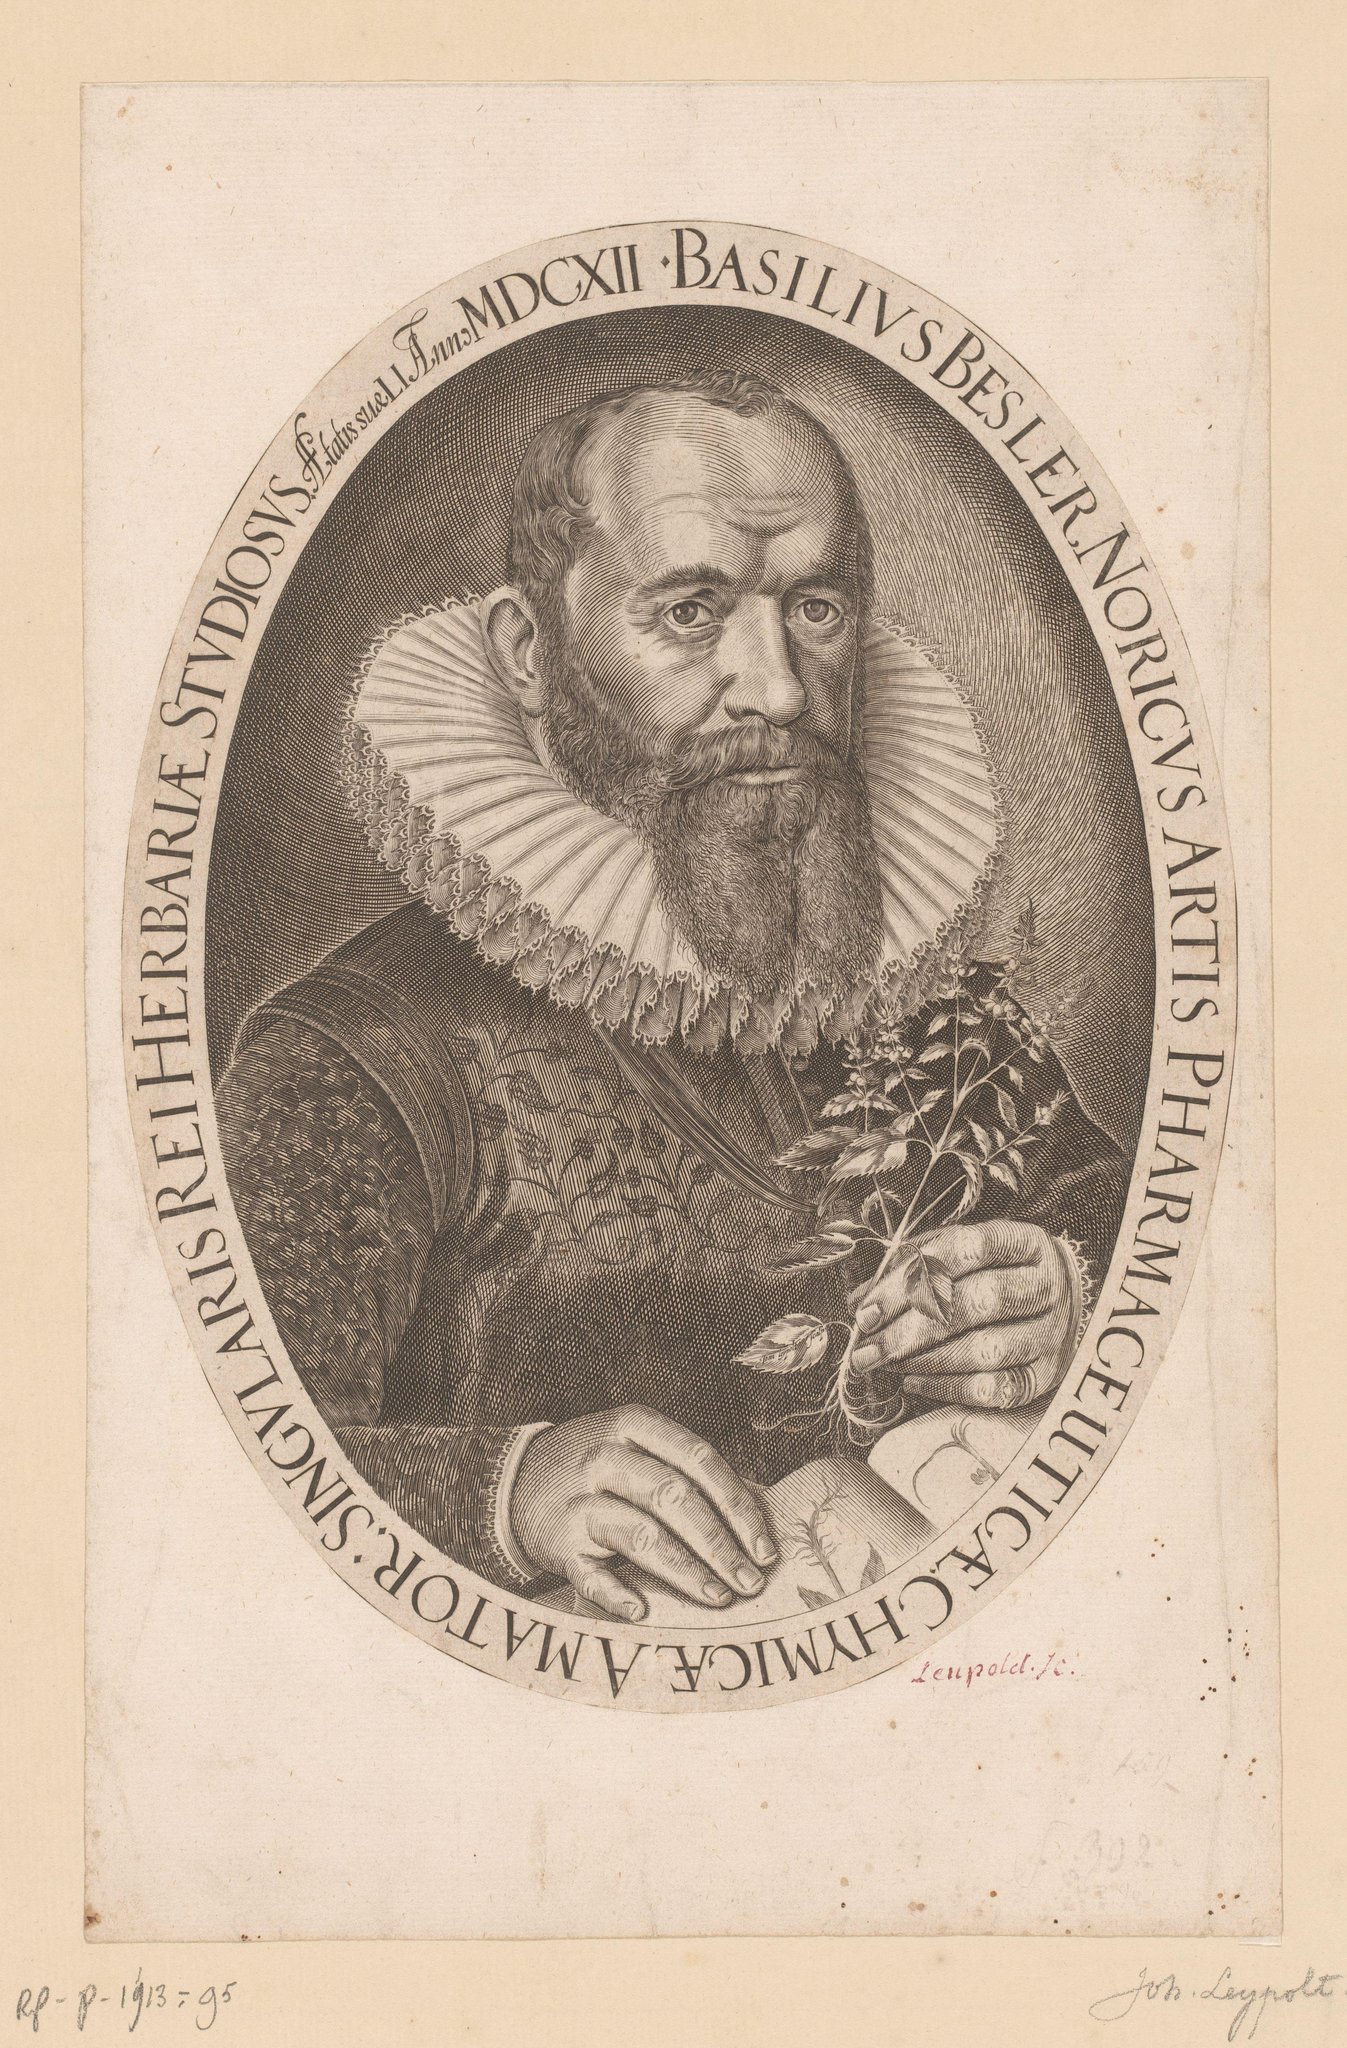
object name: print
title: Portret van Basilius Besler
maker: johann leipolt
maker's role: draughtsman, print maker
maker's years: 1620-1621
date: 1613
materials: paper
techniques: engraving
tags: historical persons, botany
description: Prent ook gebruikt in: Besler, Basilius. Hortus Eystettensis. Neurenberg: s.n., 1613.